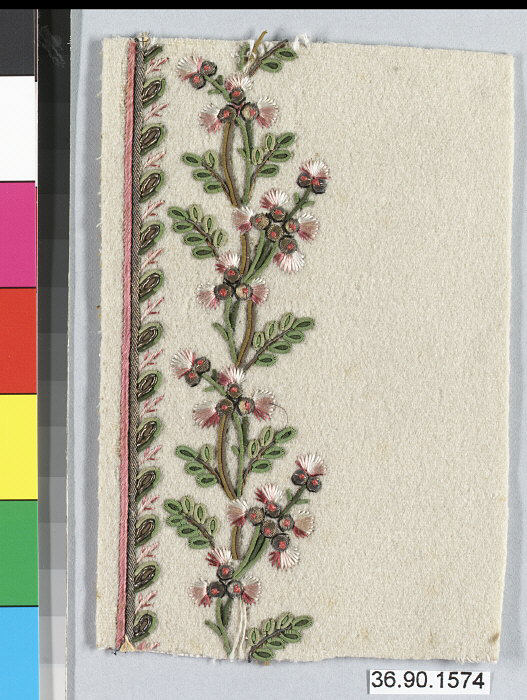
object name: sample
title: Embroidery sample for a man’s suit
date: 1785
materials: metal thread, silk, wool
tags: flowers